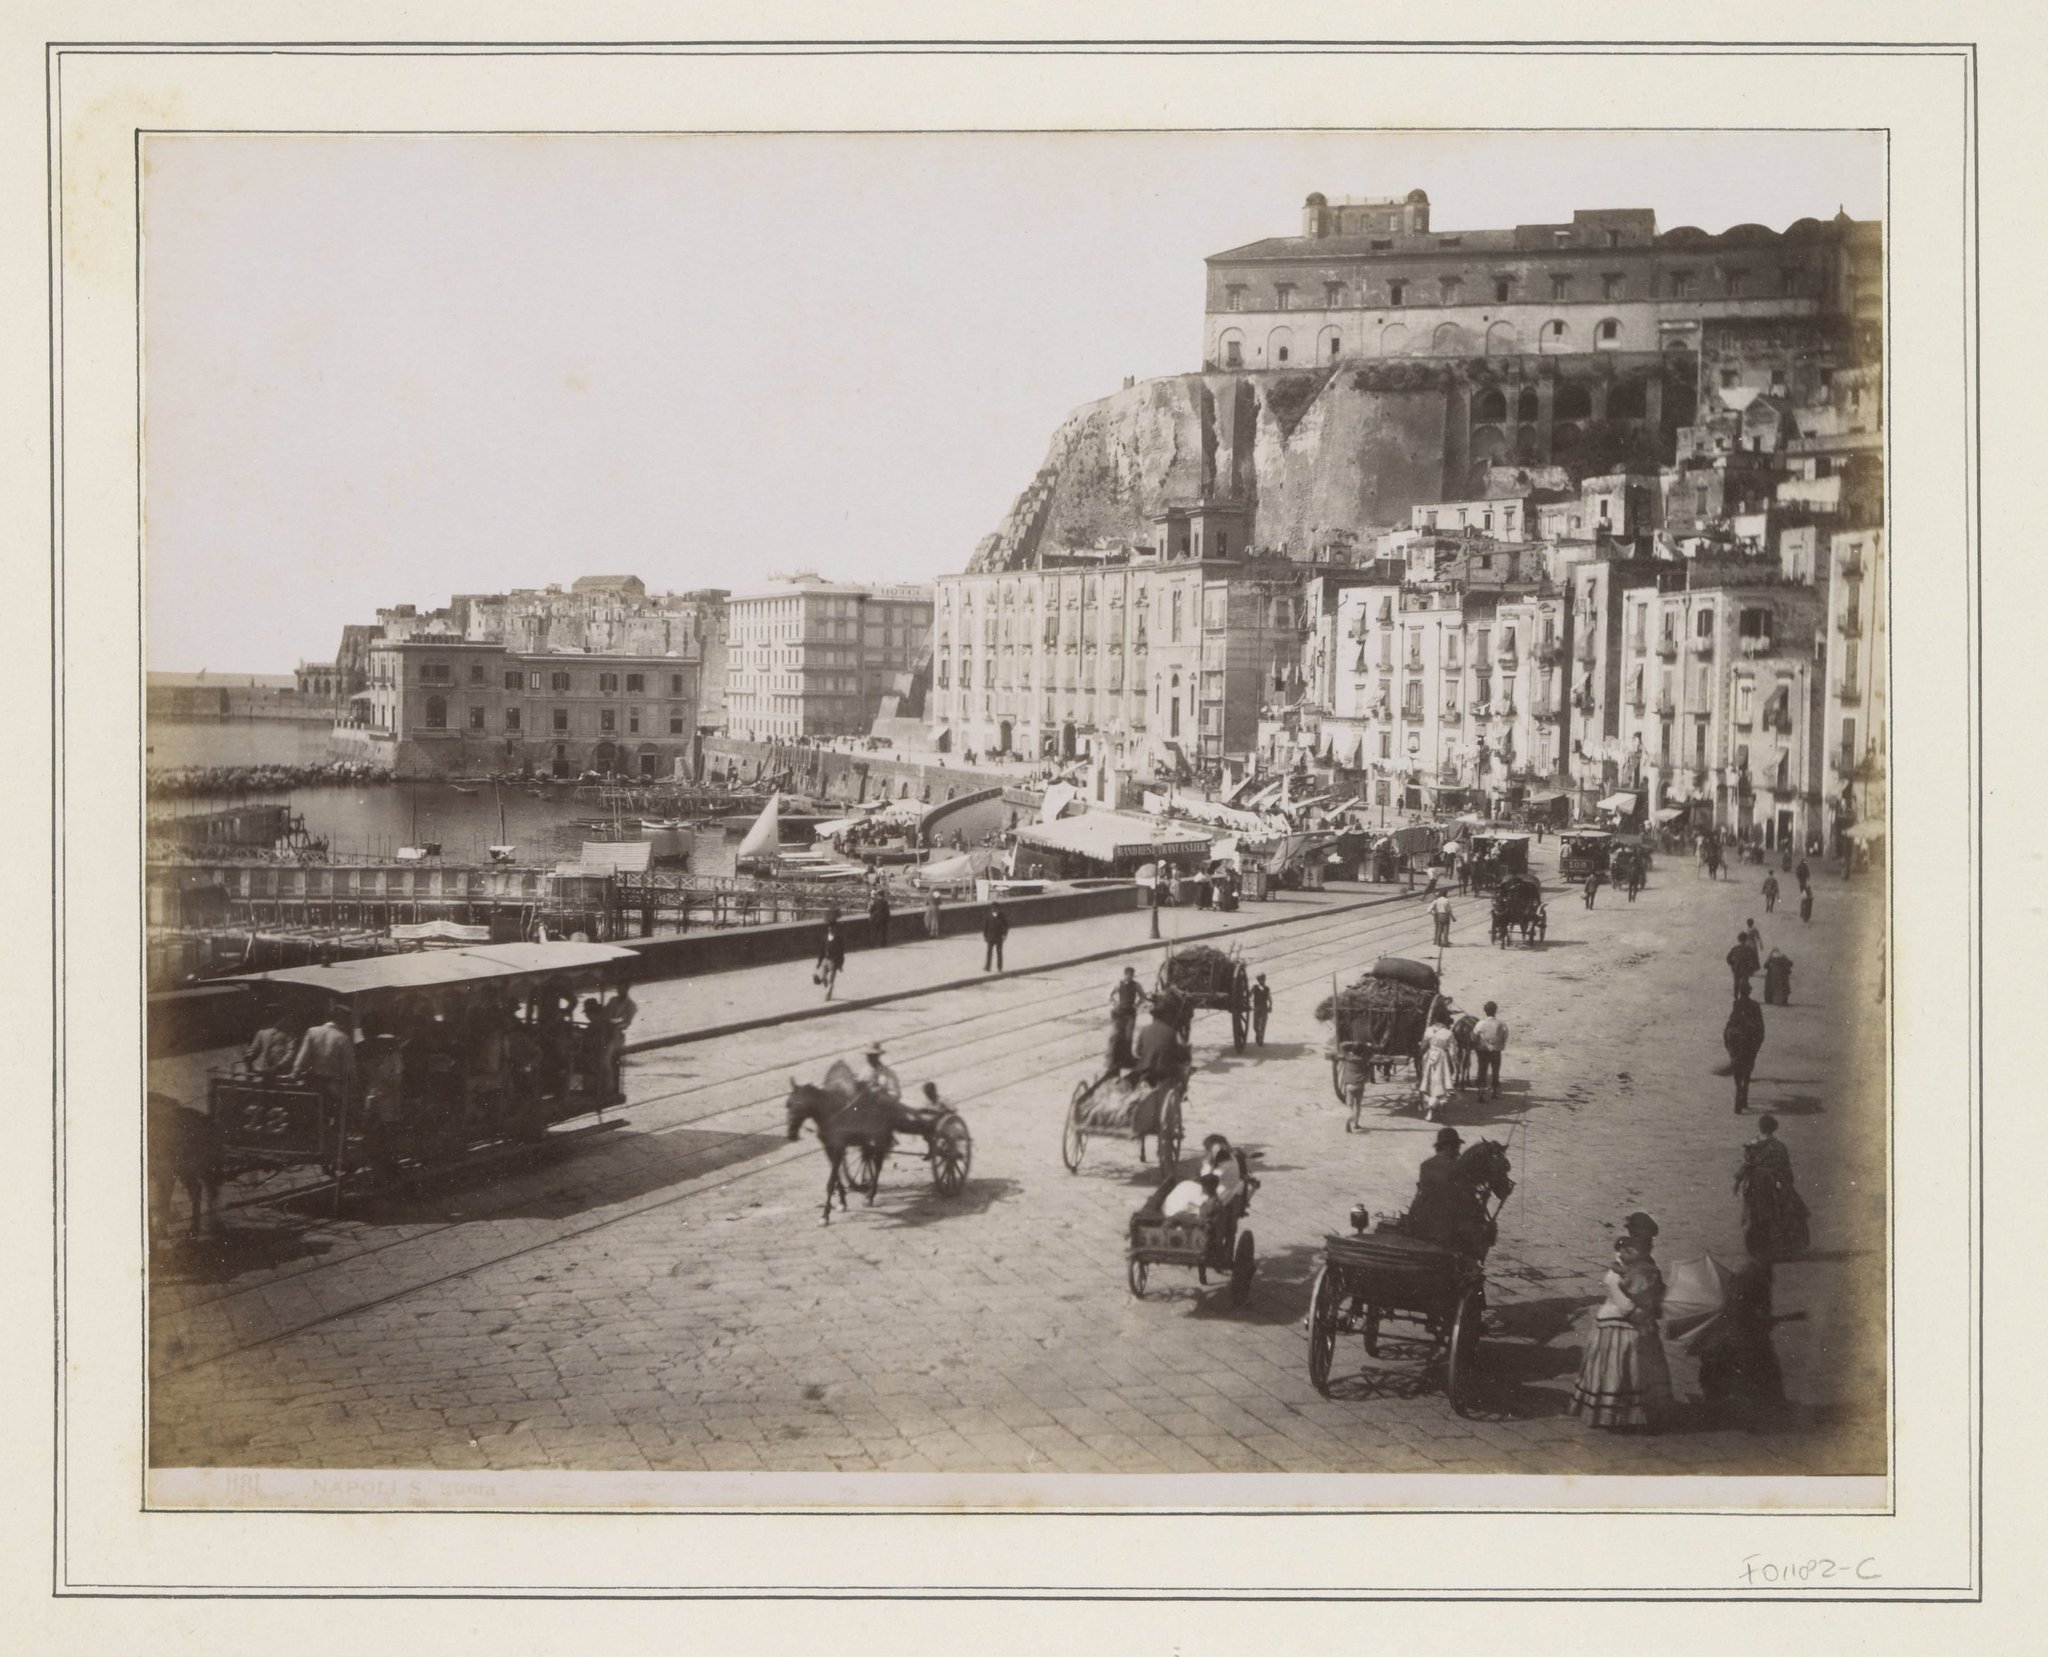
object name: photograph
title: NAPOLI - S. Lucia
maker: giorgio sommer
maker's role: fotograaf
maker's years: 1834-1914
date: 1860-1890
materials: paper, photographic support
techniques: albumen print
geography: naples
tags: diligence, omnibus, horse-tram, two-wheeled, animal-drawn vehicle, quay (+ city(-scape) with figures, staffage), naples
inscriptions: negative number: ‘1181’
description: Onderdeel van Reisalbum met foto's van bezienswaardigheden in Italië en aan de Franse Rivièra (deel II).